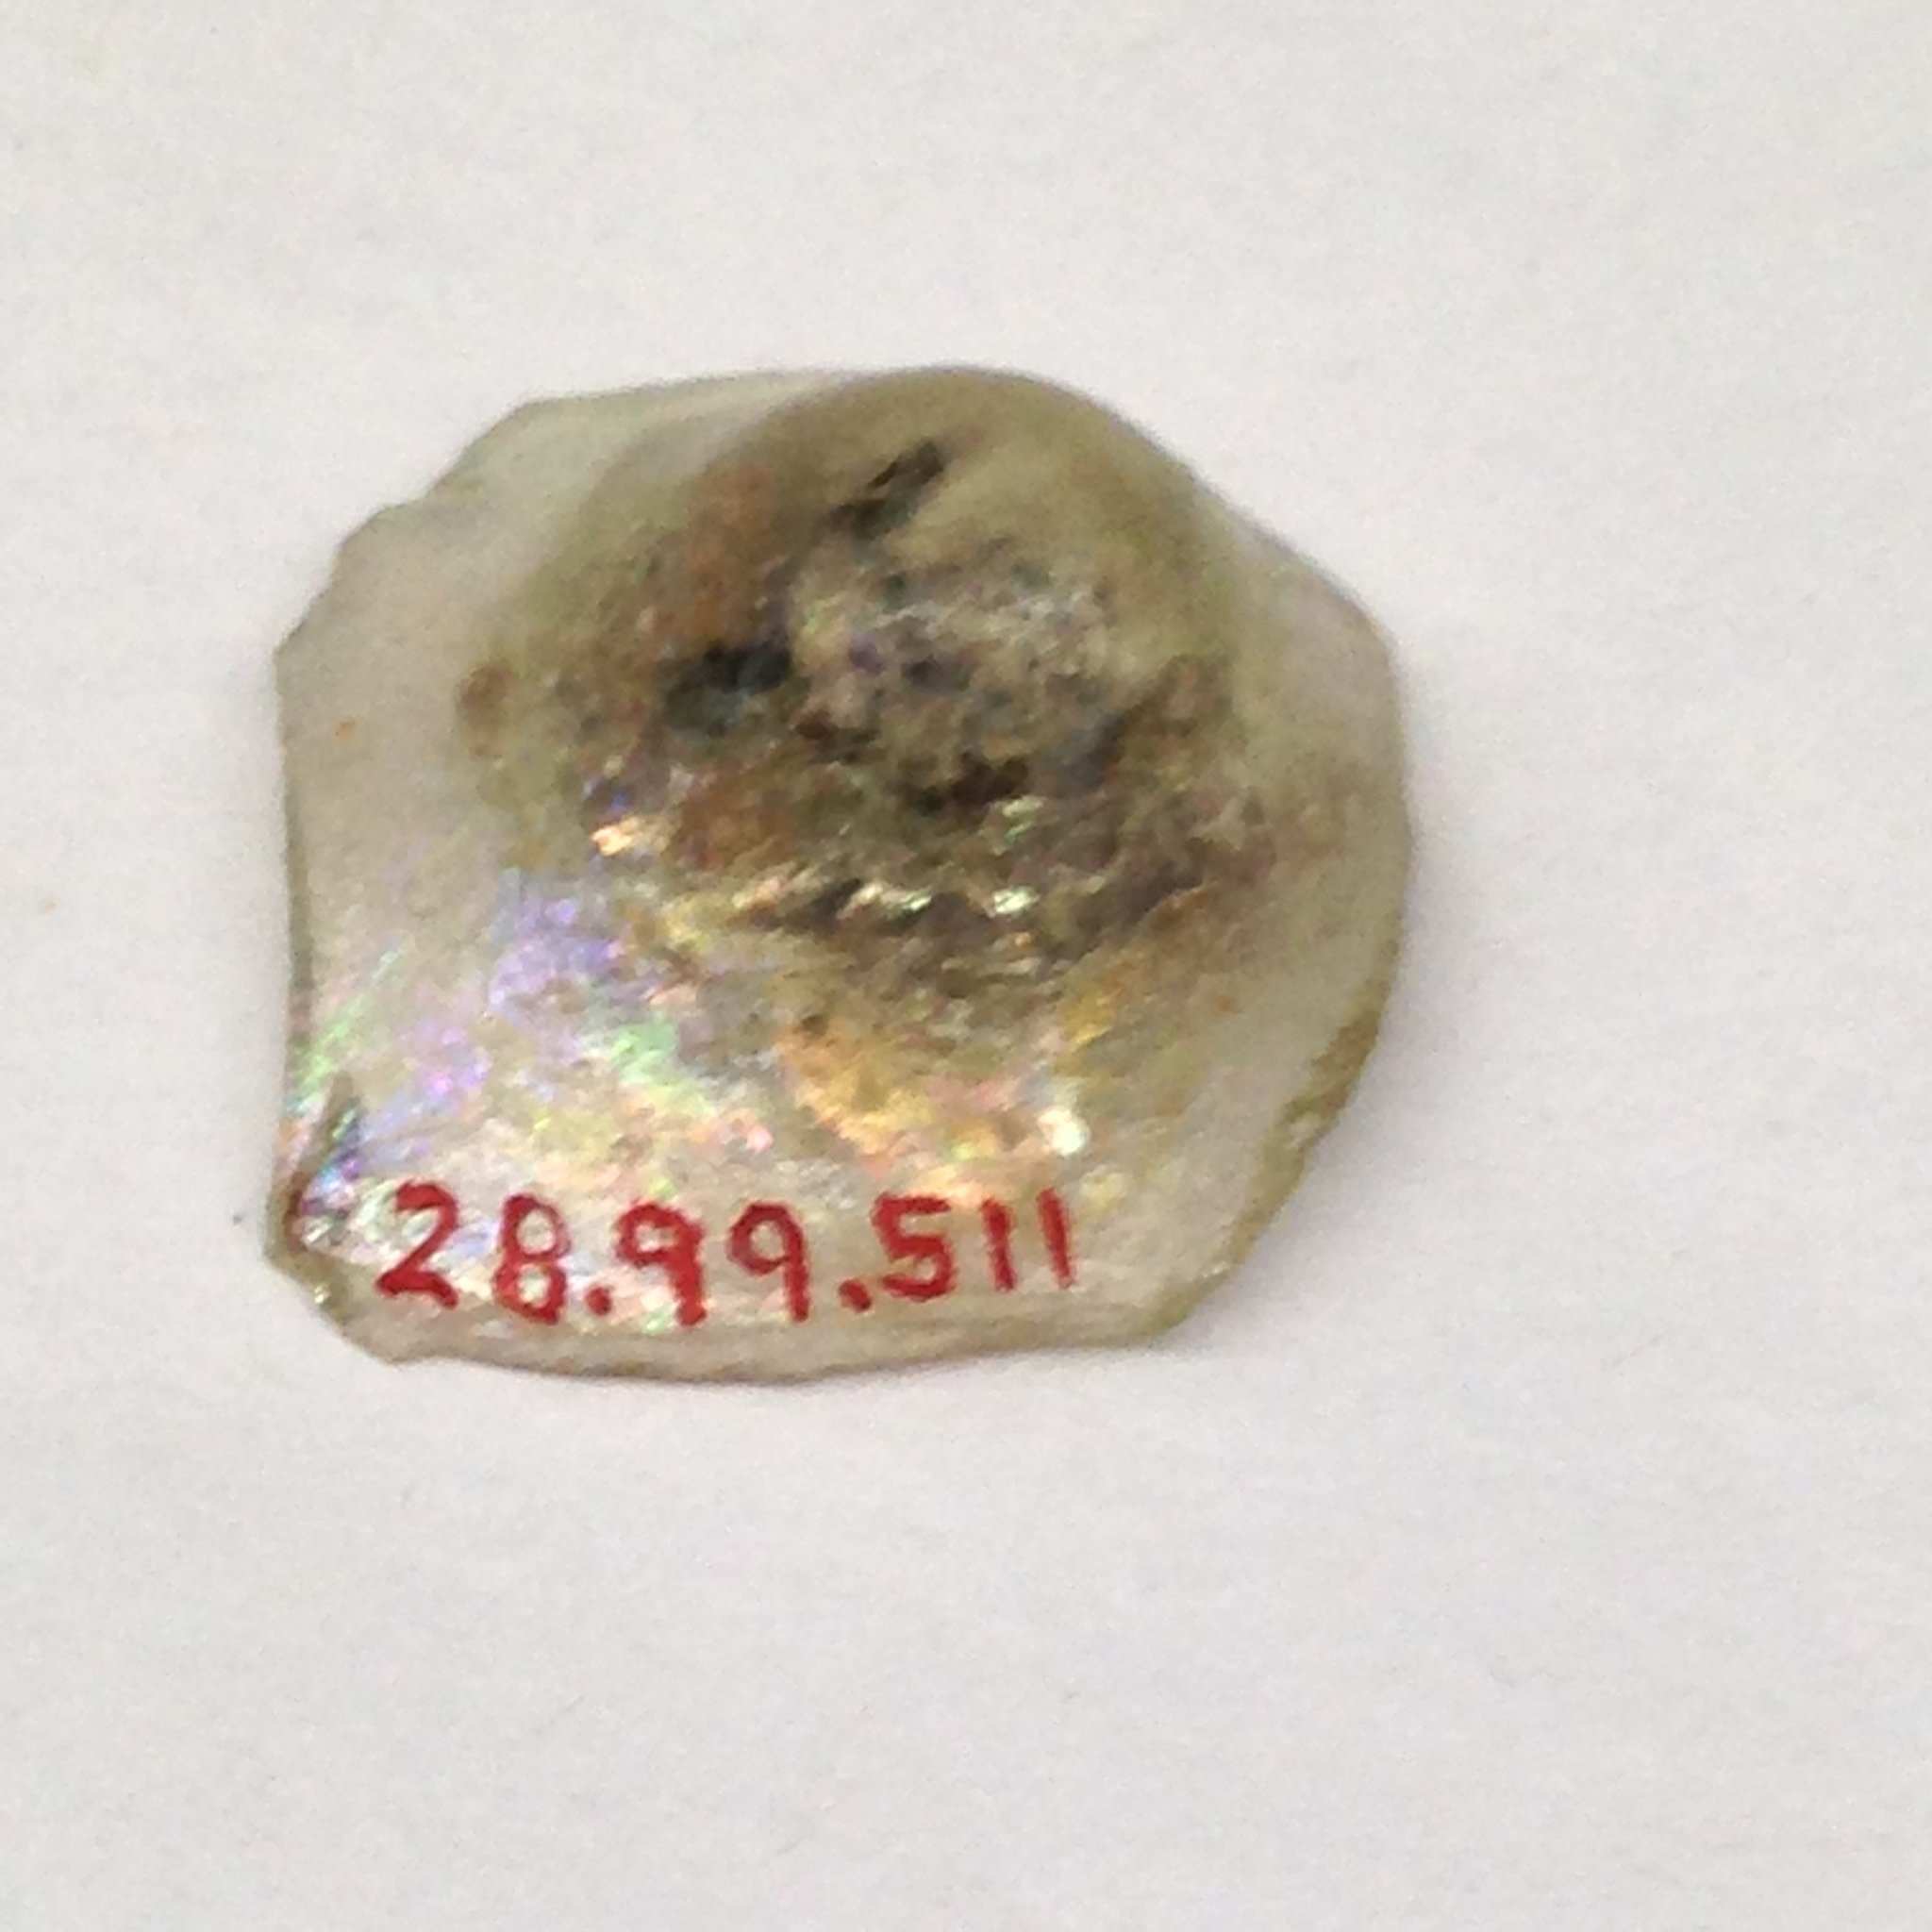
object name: fragment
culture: european or middle eastern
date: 1150-1250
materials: ceramic, glass